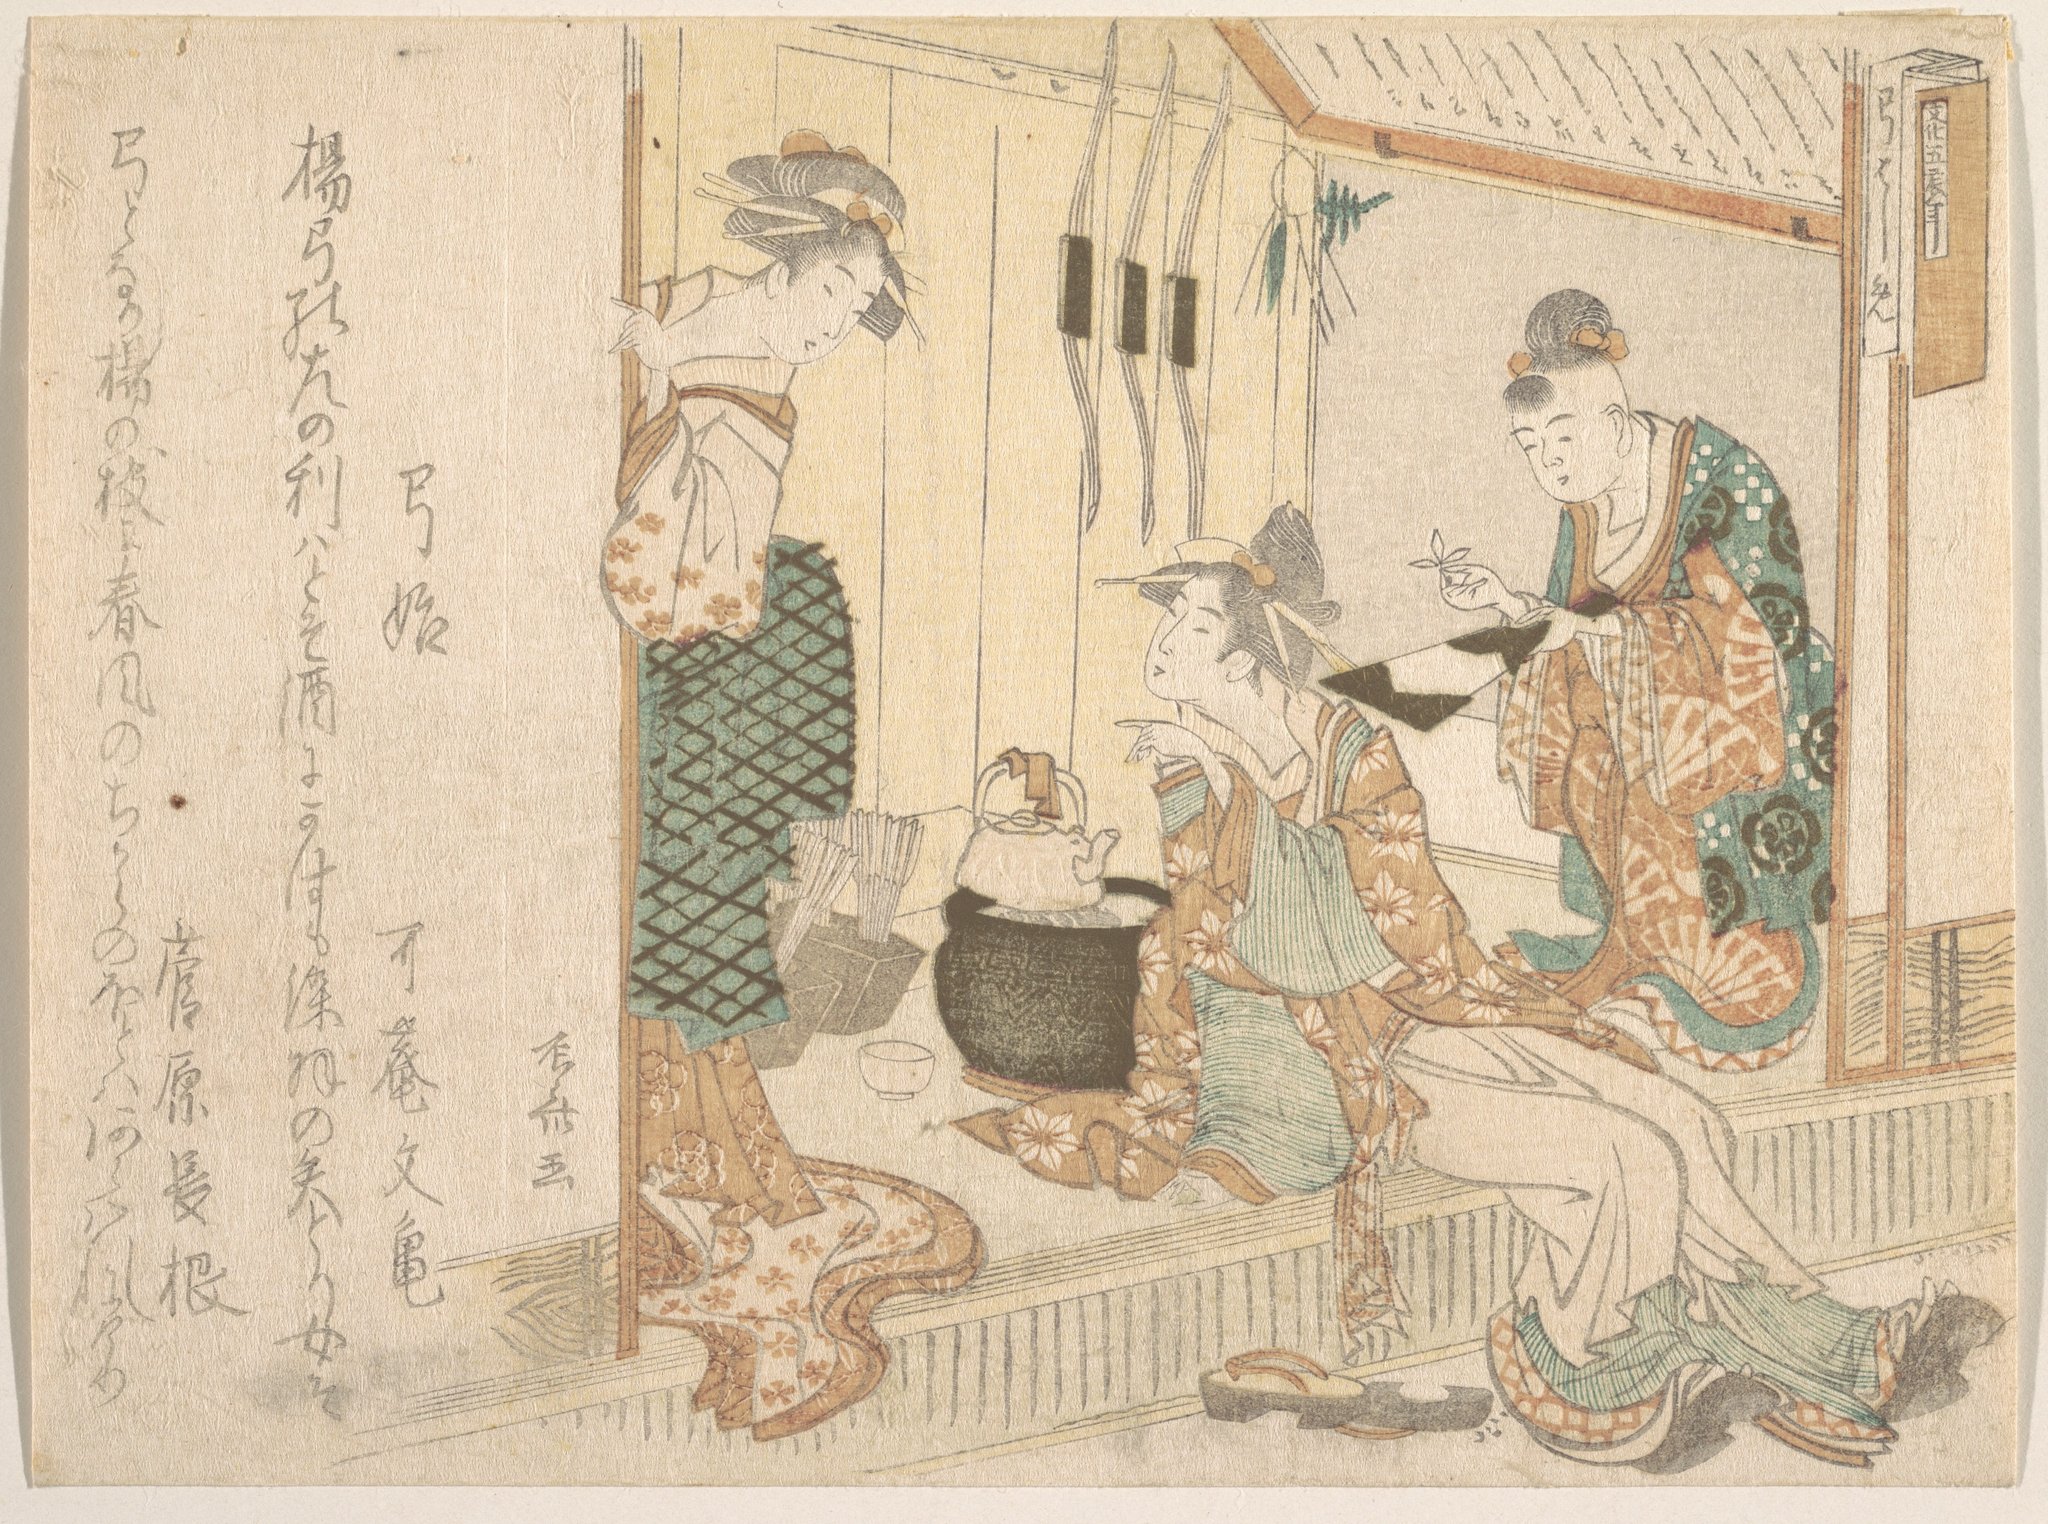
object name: print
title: Two Young Ladies Having Tea Attended by Elderly Servant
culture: japanese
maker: ryūryūkyo shinsai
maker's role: artist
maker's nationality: japanese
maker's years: 1799-1823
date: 1750-1835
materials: ink, paper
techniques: surimono, woodblock print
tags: women,tea drinking,servants,teapots